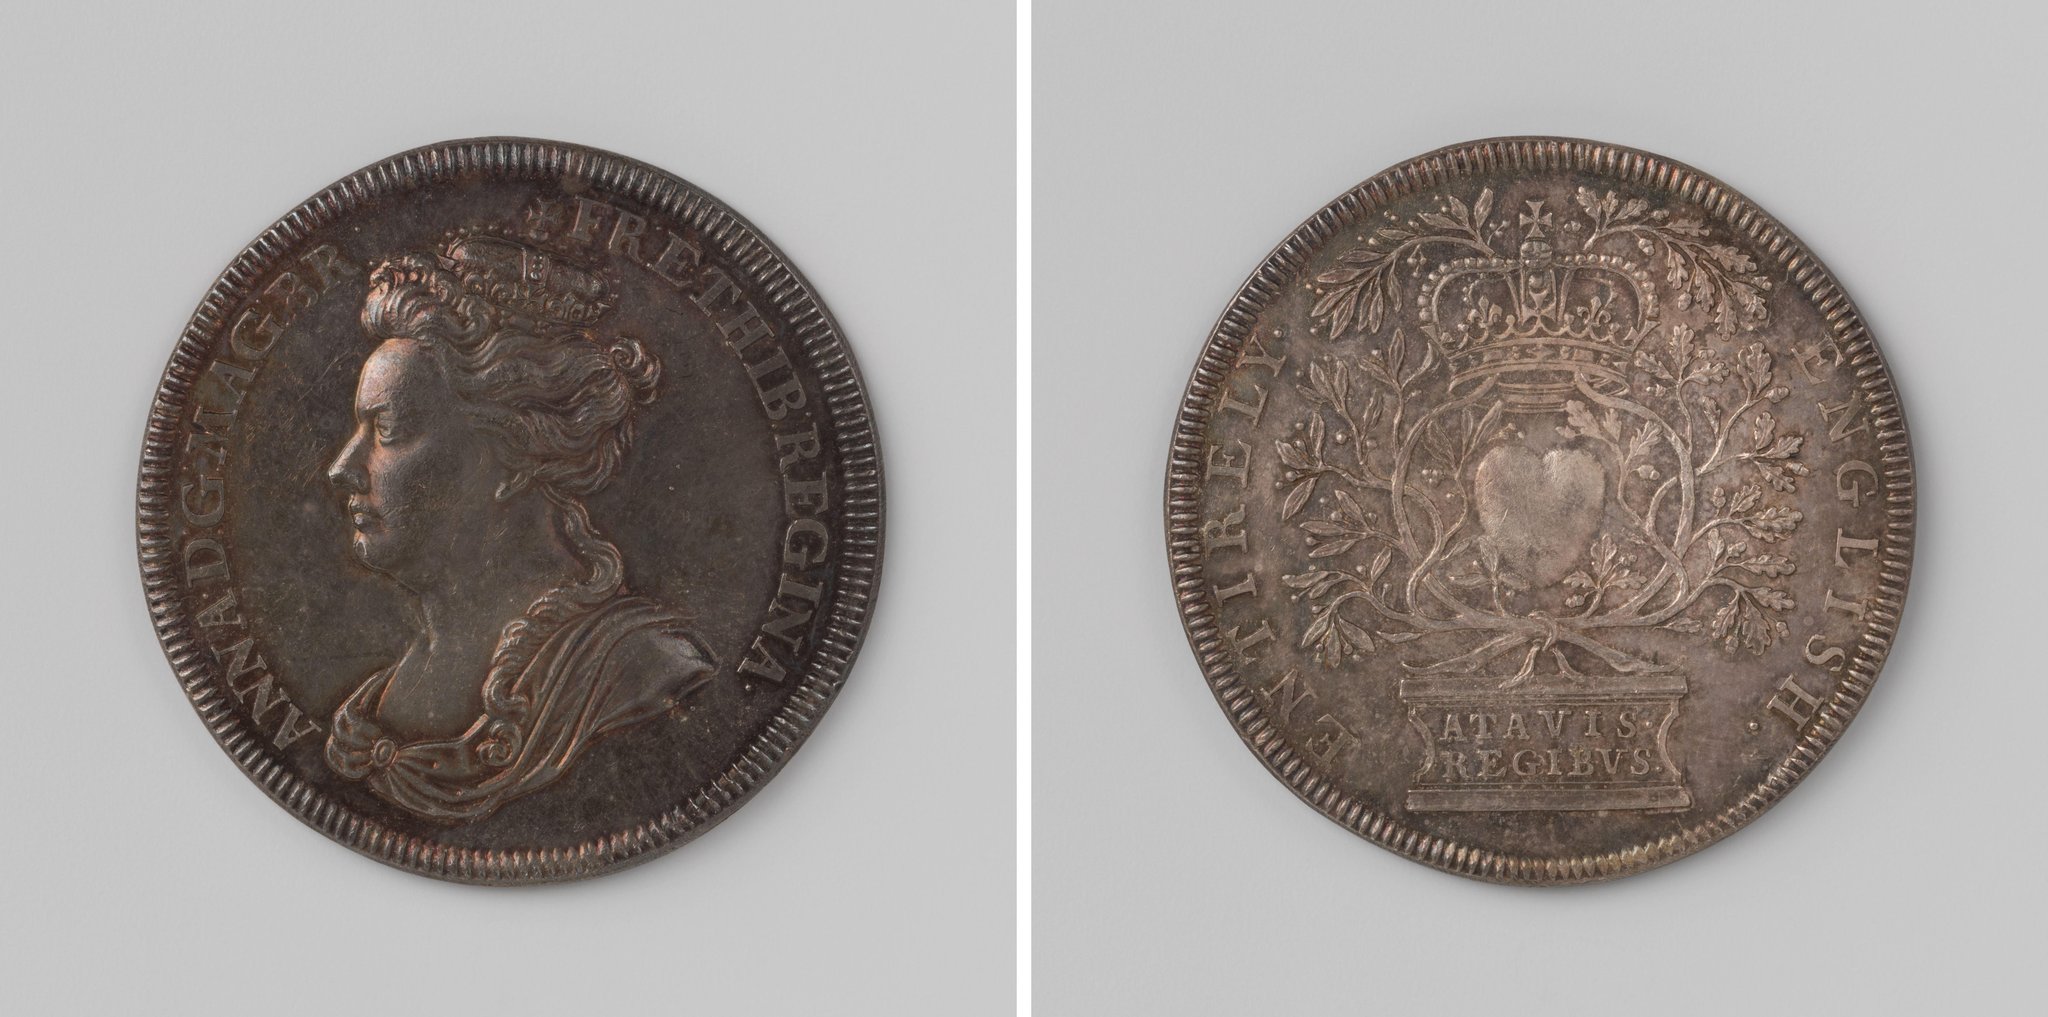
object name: history medal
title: Anna tot koningin van Engeland gekozen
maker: john croker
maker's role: die cutter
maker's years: 1670-1741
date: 1702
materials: silver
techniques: striking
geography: london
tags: anna stuart (koningin van engeland en schotland)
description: Zilveren penning. Voorzijde: borststuk vrouw met kroon binnen omschrift. Keerzijde: hart tussen samengebonden eiken- en lauwertak onder kroon op voetstuk binnen omschrift